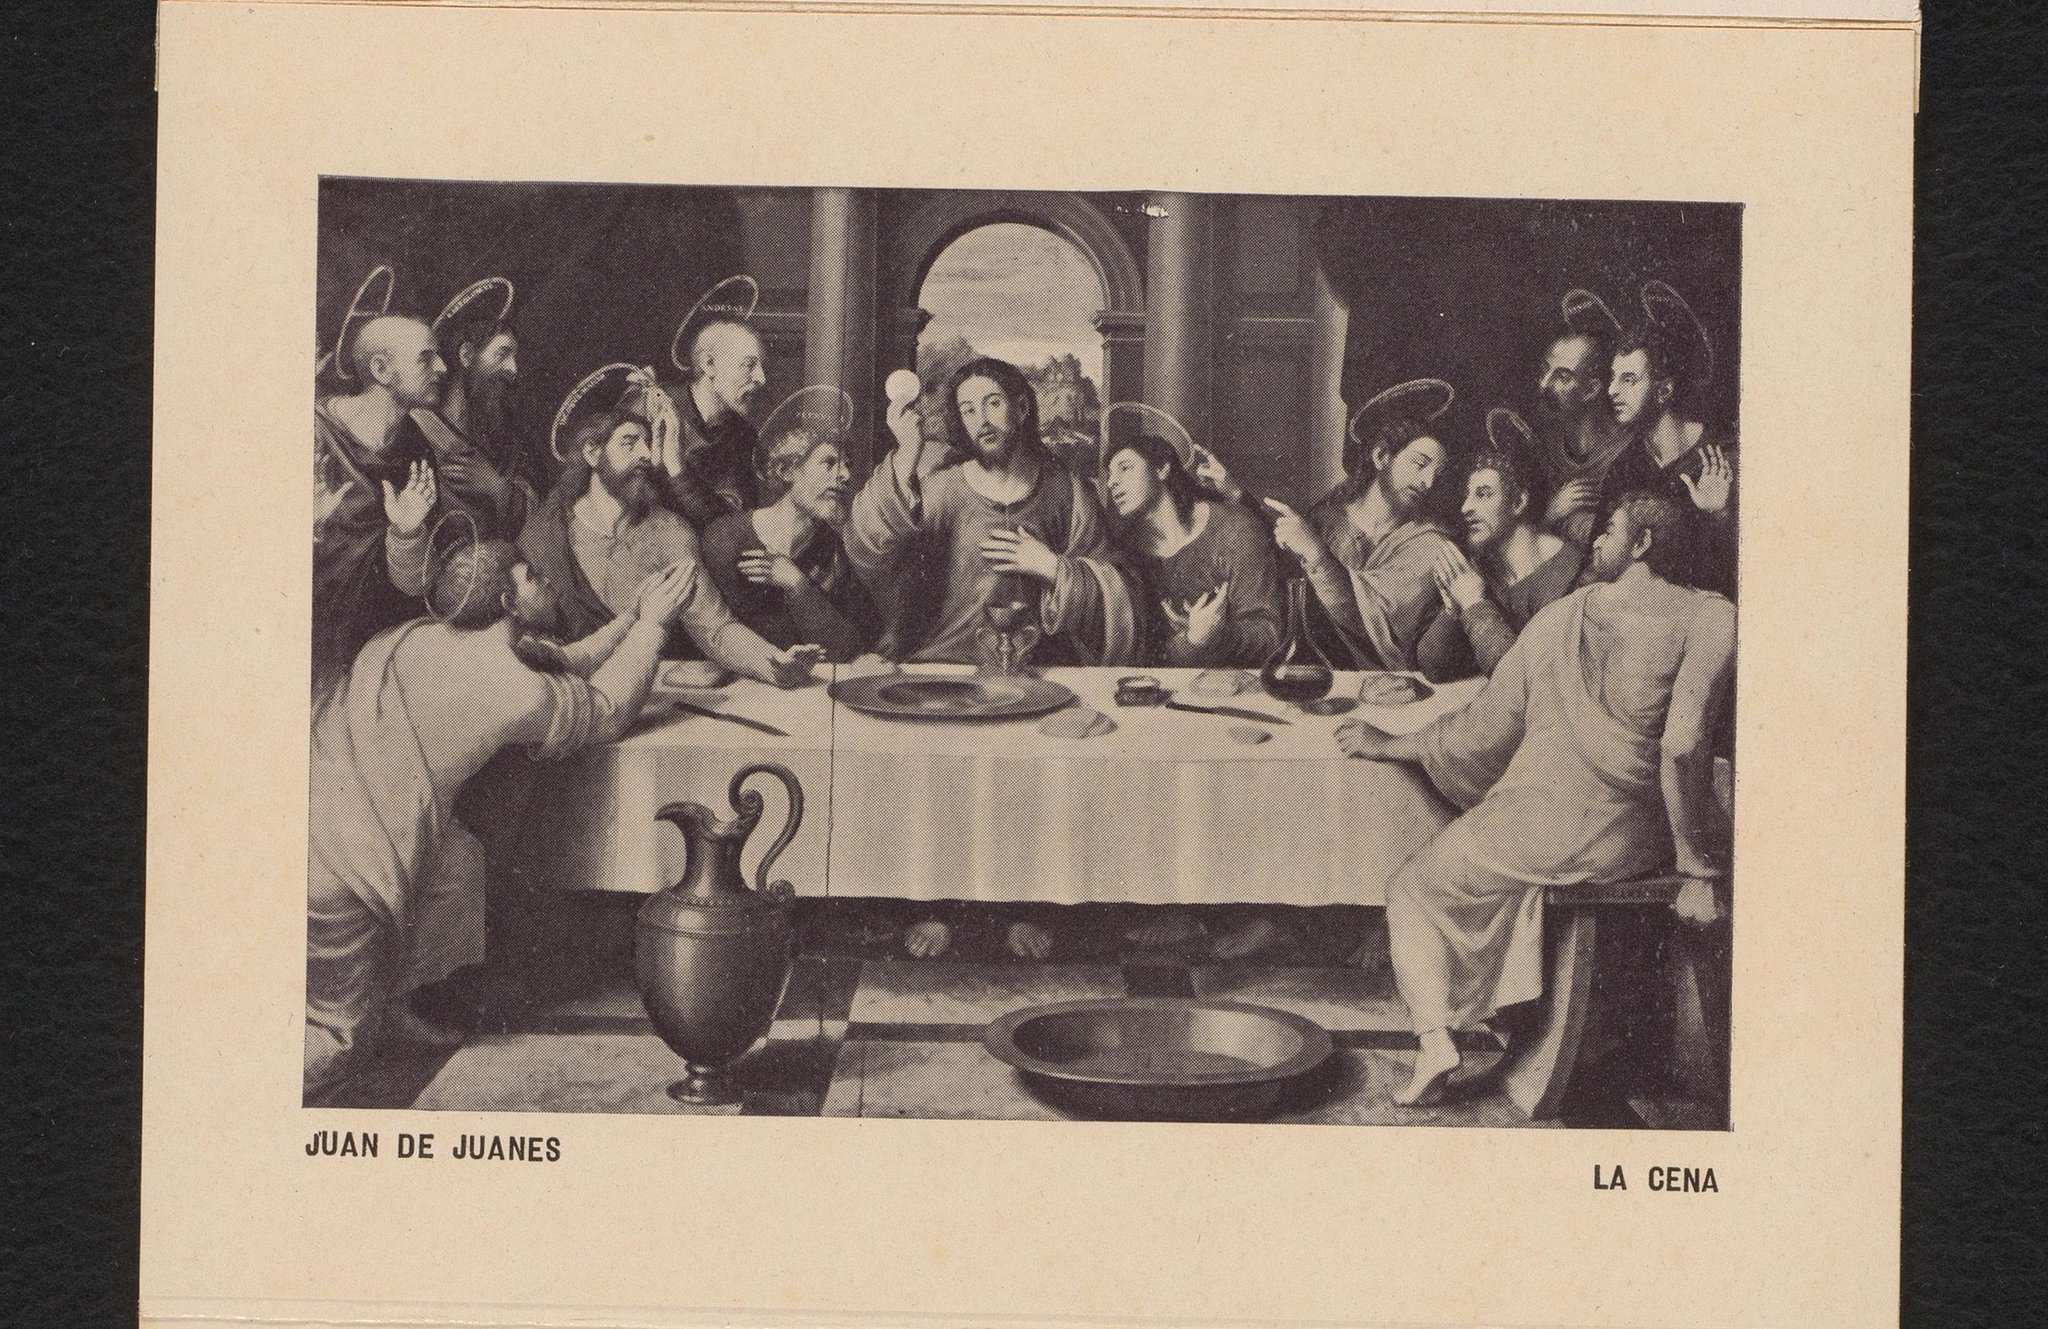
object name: reproduction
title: Juan de Juanes. Le cena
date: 1910-1950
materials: cardboard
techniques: autotype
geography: madrid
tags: permanent exhibition, museum, picture, painting